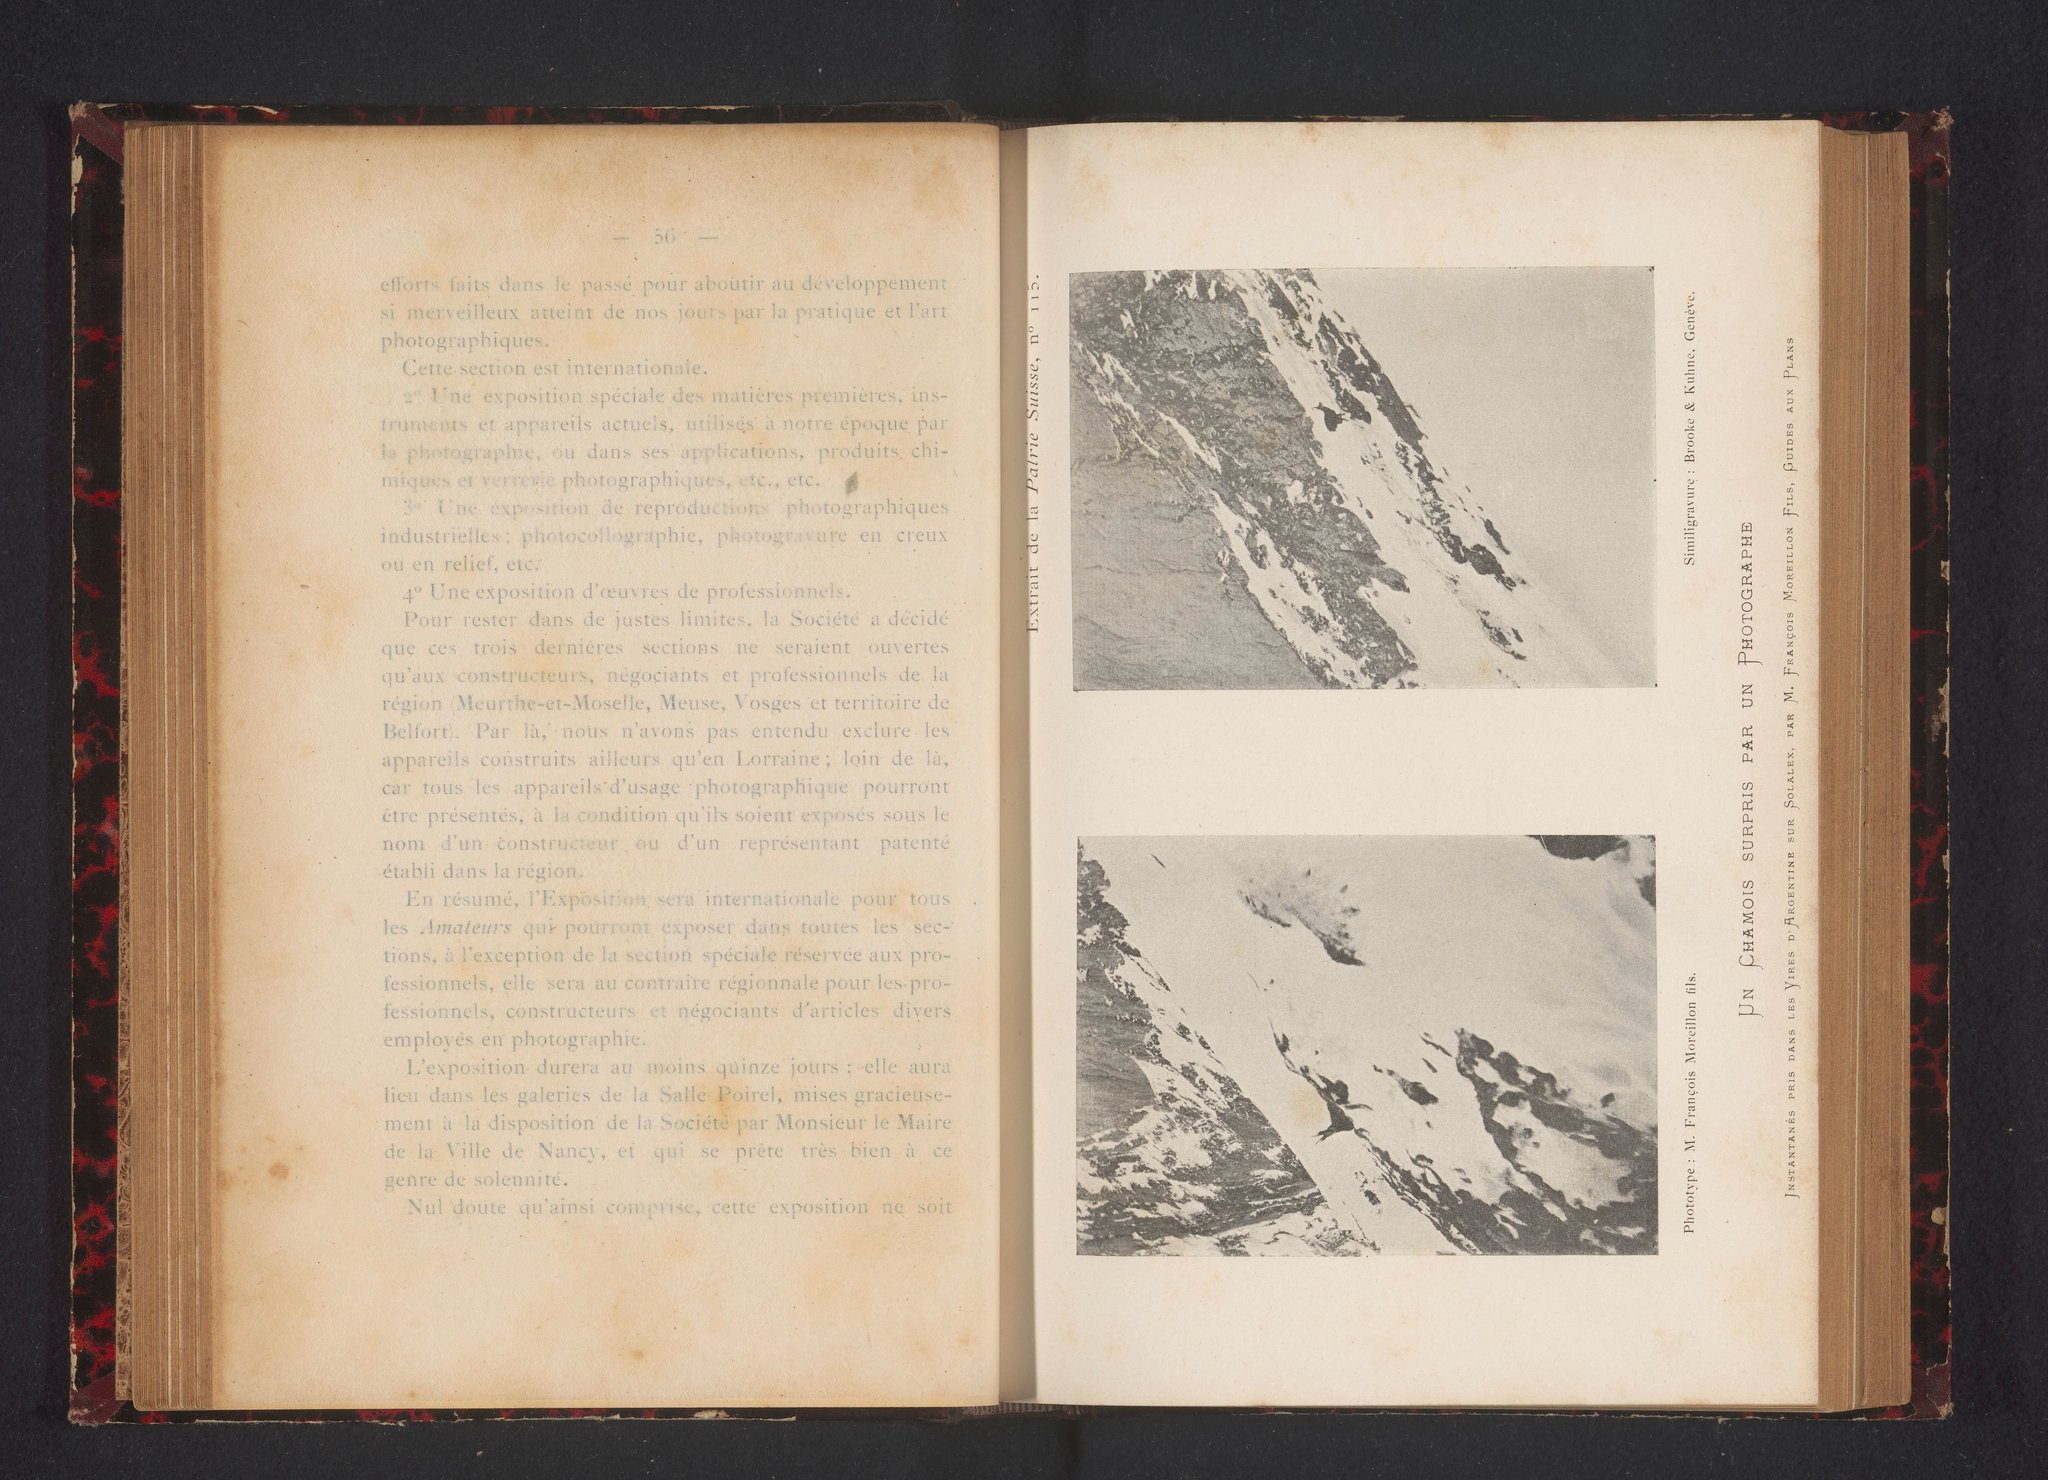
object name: photomechanical print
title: Un Chamois surpris par un Photographie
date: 1893-1898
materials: paper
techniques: autotype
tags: hoofed animals: chamois, snow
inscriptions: inscription: ‘Instantanés pris dans les Vires d'Argentine sur Solalex, par M. François Moreillon Fils, Guides aux Plans.’, inscription: ‘Extrait de la Patrie Suisse, No 115.’